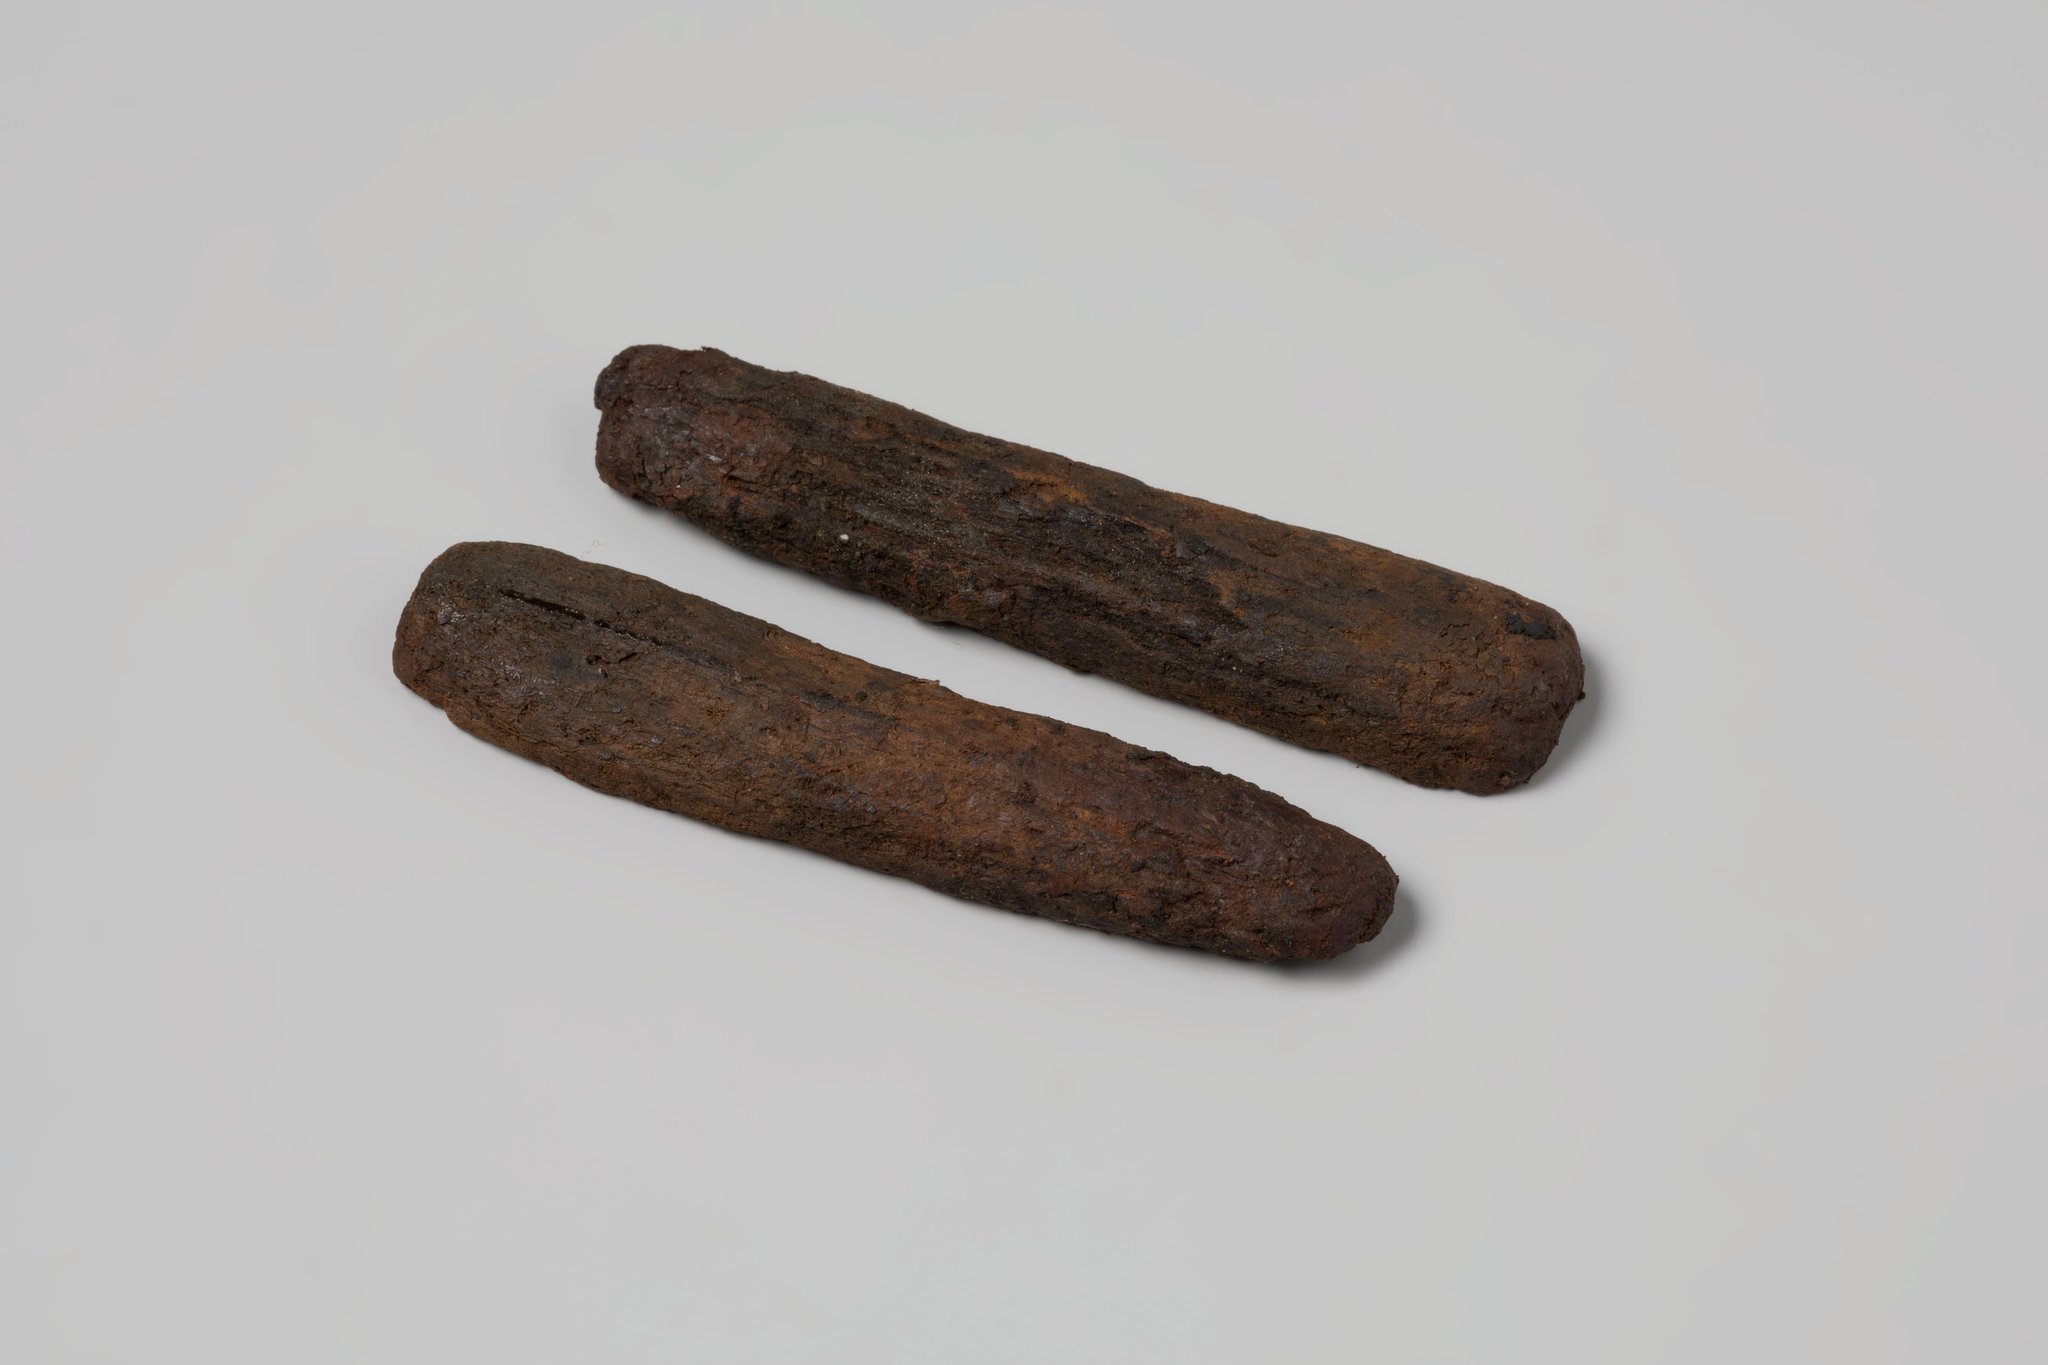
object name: knife handle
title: Messenheft uit het wrak van de Oost-Indiëvaarder Hollandia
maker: Anonymous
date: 1700-1743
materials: wood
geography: netherlands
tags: verenigde oostindische compagnie, hollandia (schip), annet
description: Knife, handle deformed: unclassifiable; fragm, sim. NG 1980-27H1678.